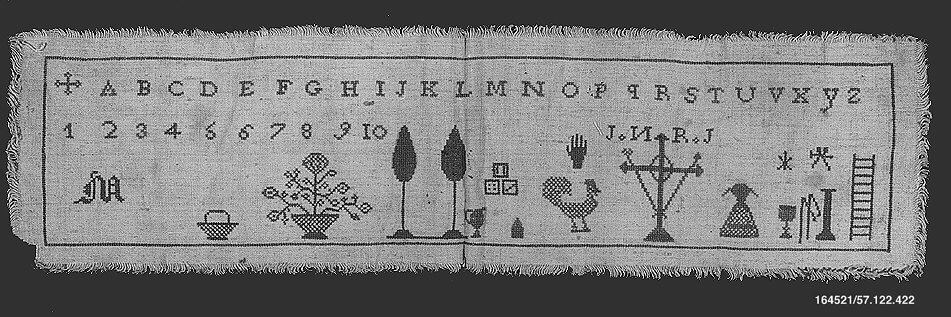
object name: sampler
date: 1801-1900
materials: cotton, linen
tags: birds